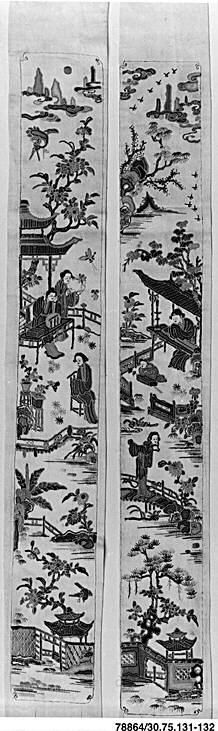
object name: sleeve band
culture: chinese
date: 1767-1800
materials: metal thread, silk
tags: human figures,houses,flowers